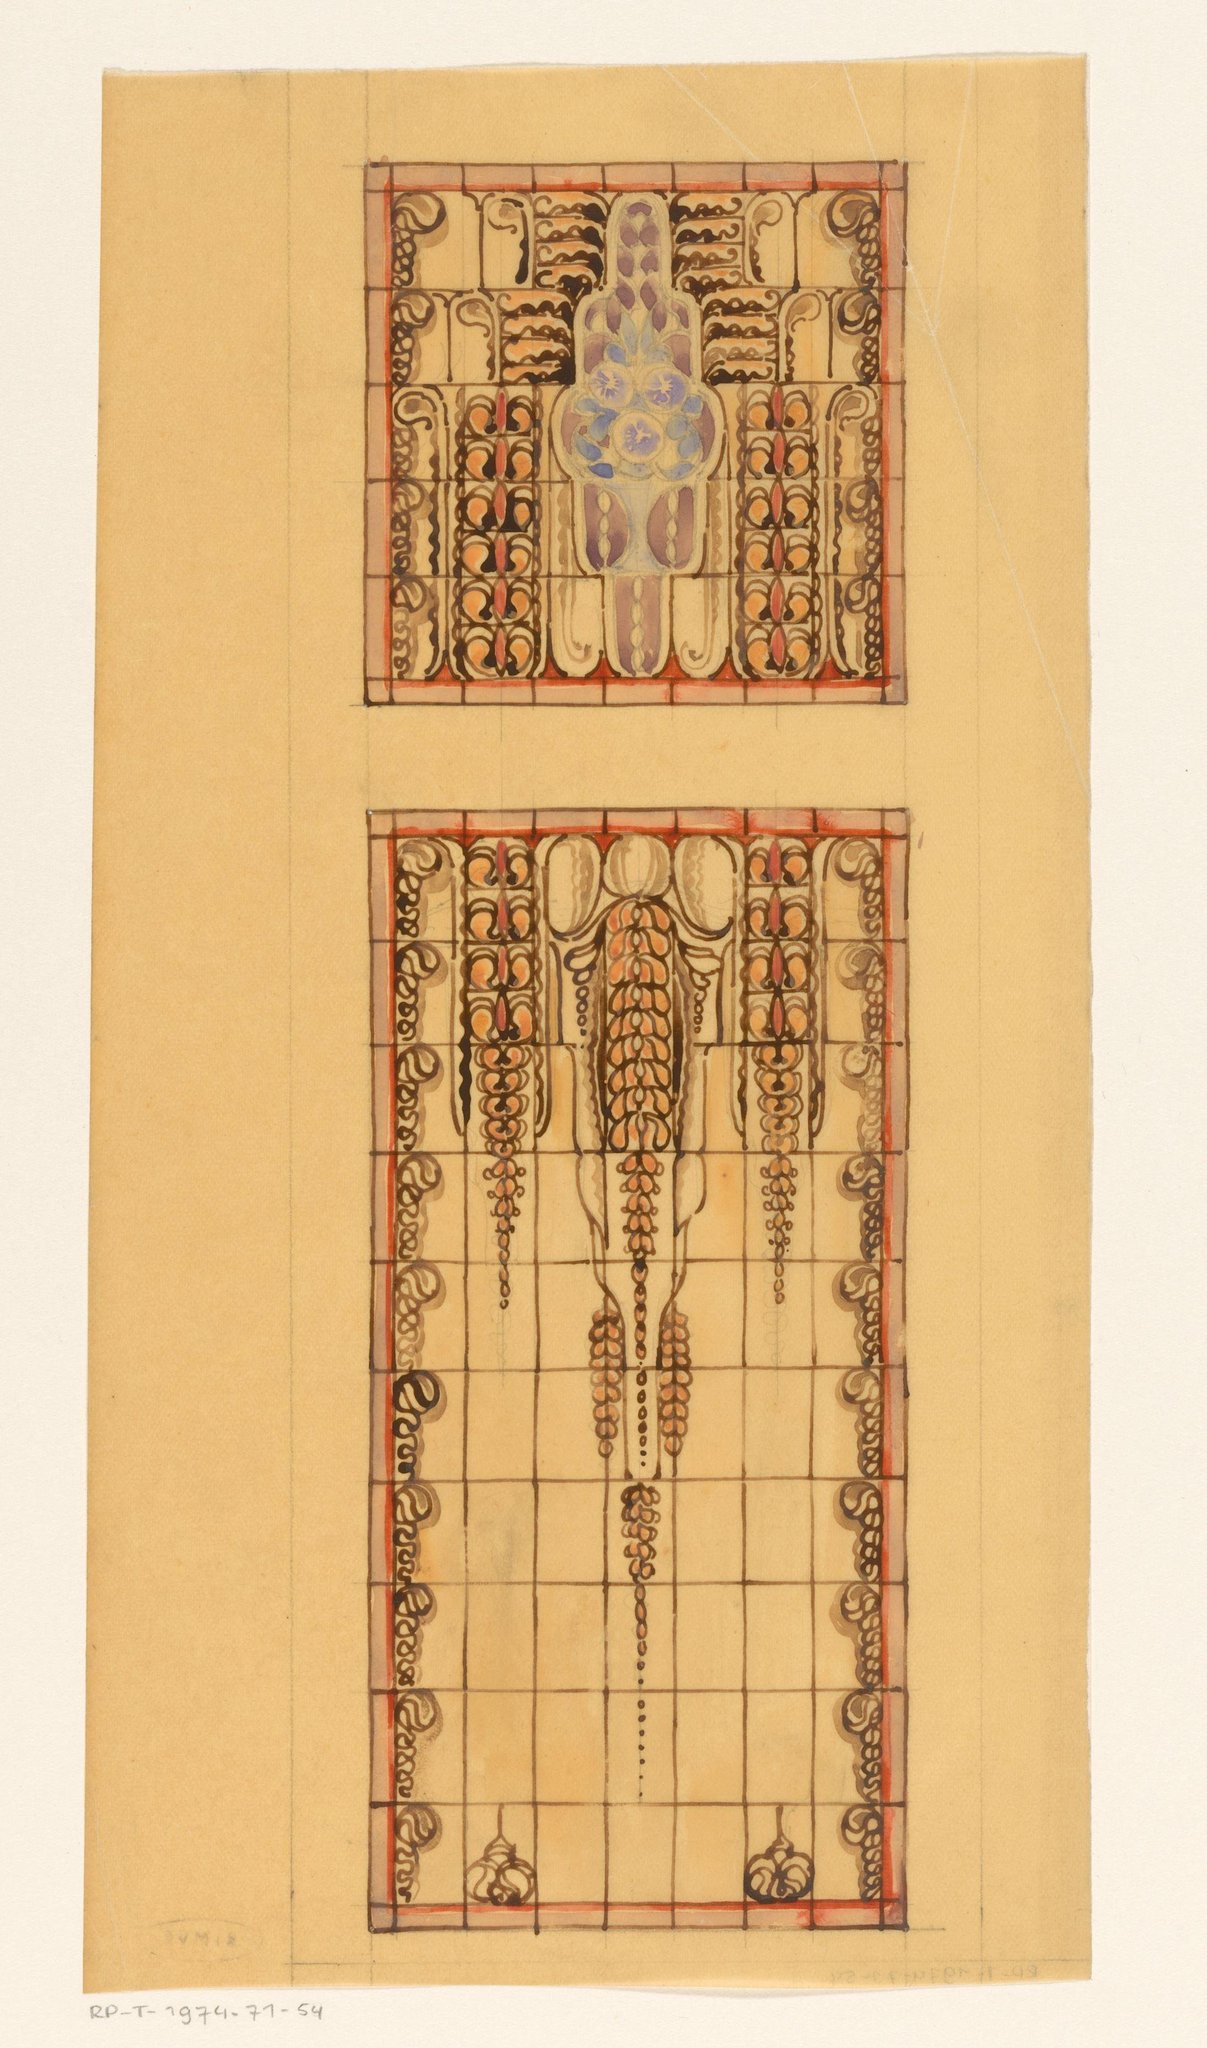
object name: drawing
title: Ontwerpen voor twee glas in loodramen met bloemornamenten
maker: Anonymous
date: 1907-1930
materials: ink, pencil, paper, watercolor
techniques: brush, pen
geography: amsterdam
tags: flowers ~ ornament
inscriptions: collector's mark: ‘R:MVS’